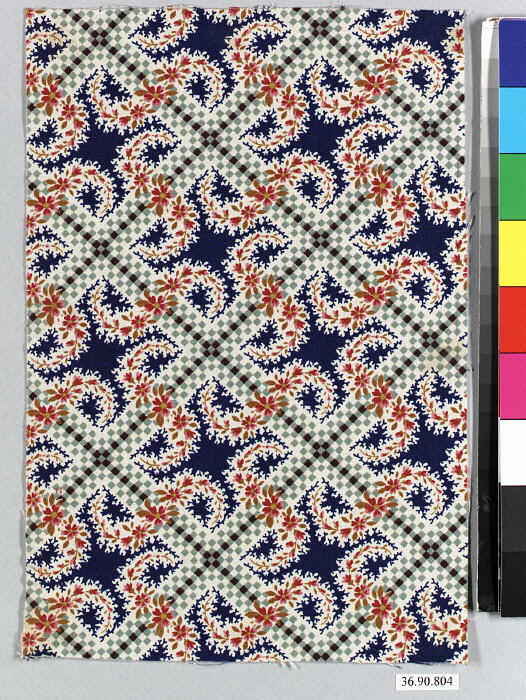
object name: piece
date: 1867-1900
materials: cotton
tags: flowers,leaves